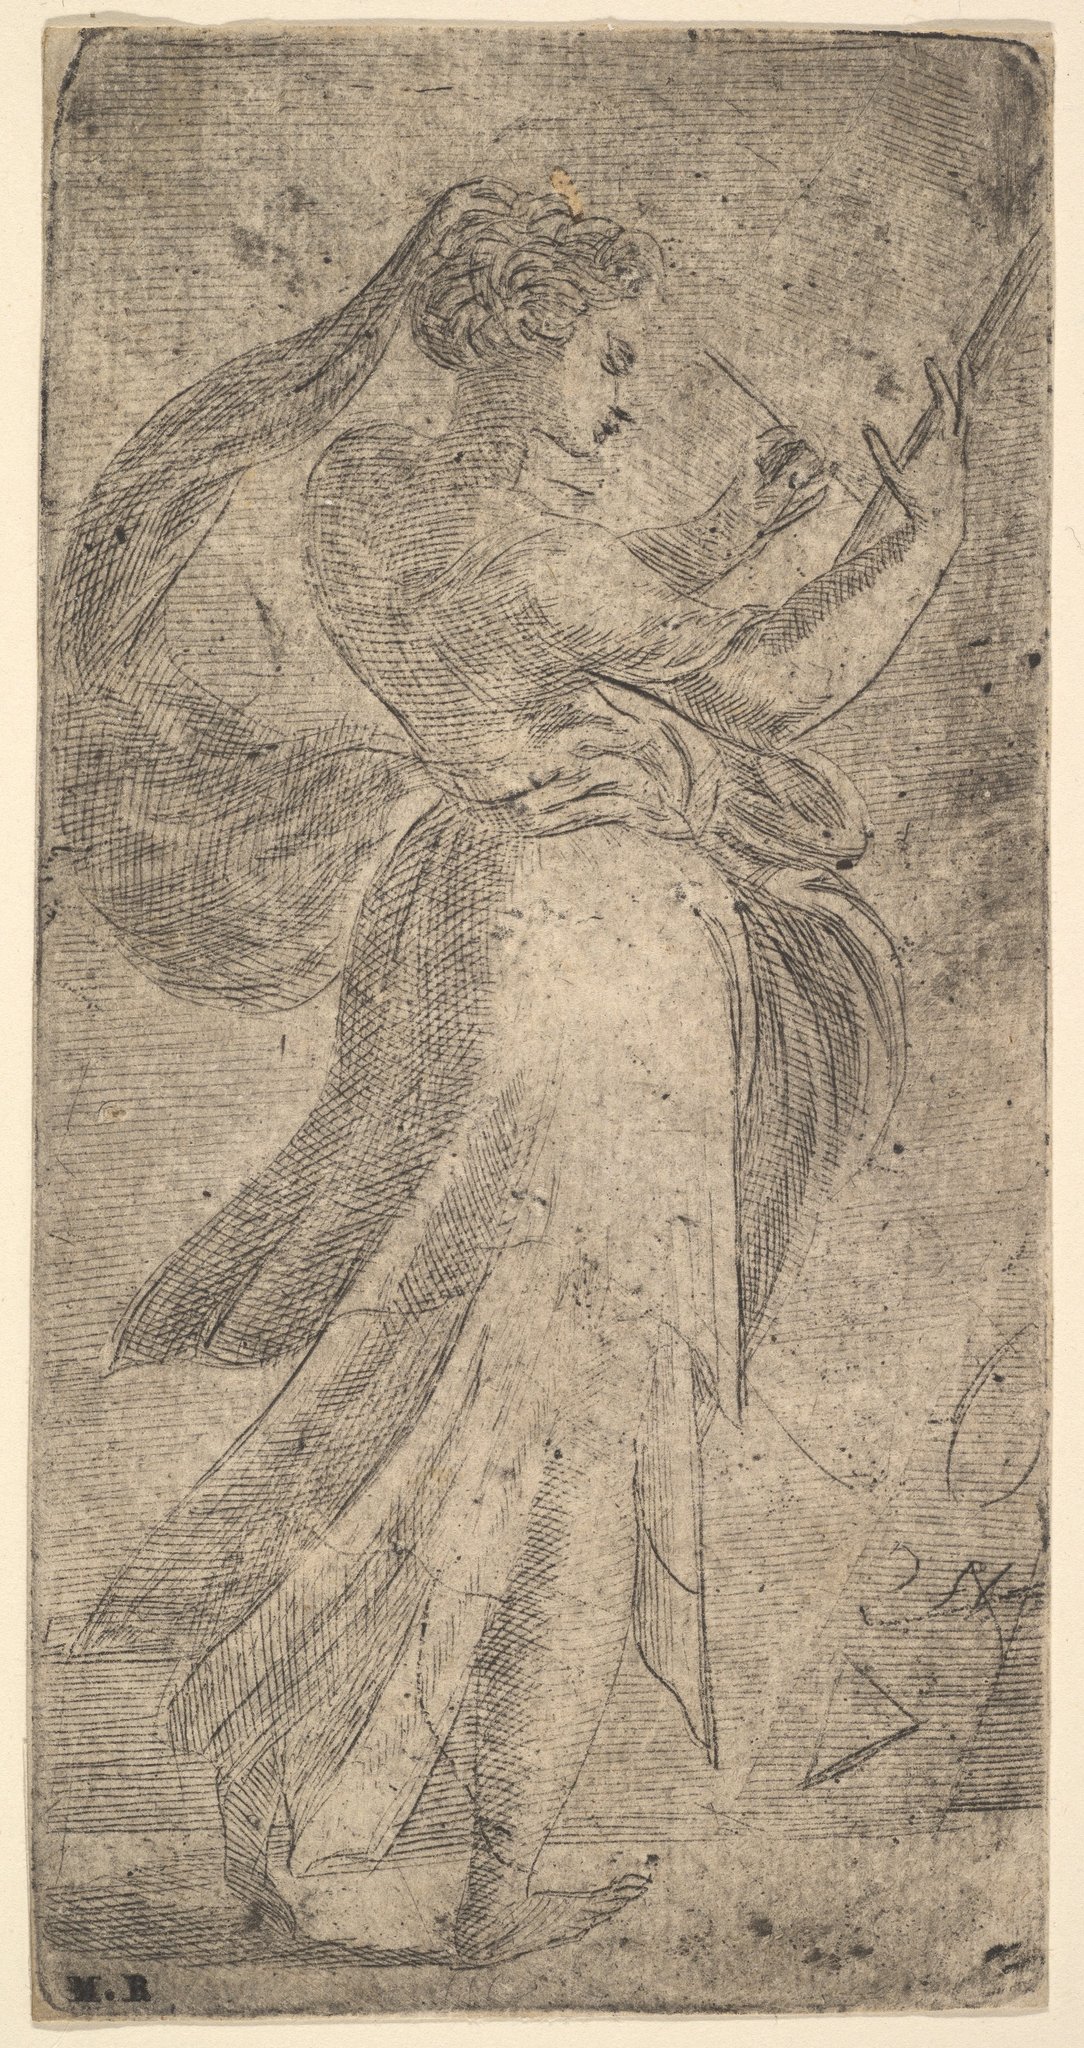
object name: print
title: A woman standing in profile, facing right and writing on a tablet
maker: andrea schiavone (andrea meldola)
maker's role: artist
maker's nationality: italian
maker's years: 1510-1563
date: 1538-1540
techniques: etching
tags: tablets,women,writing